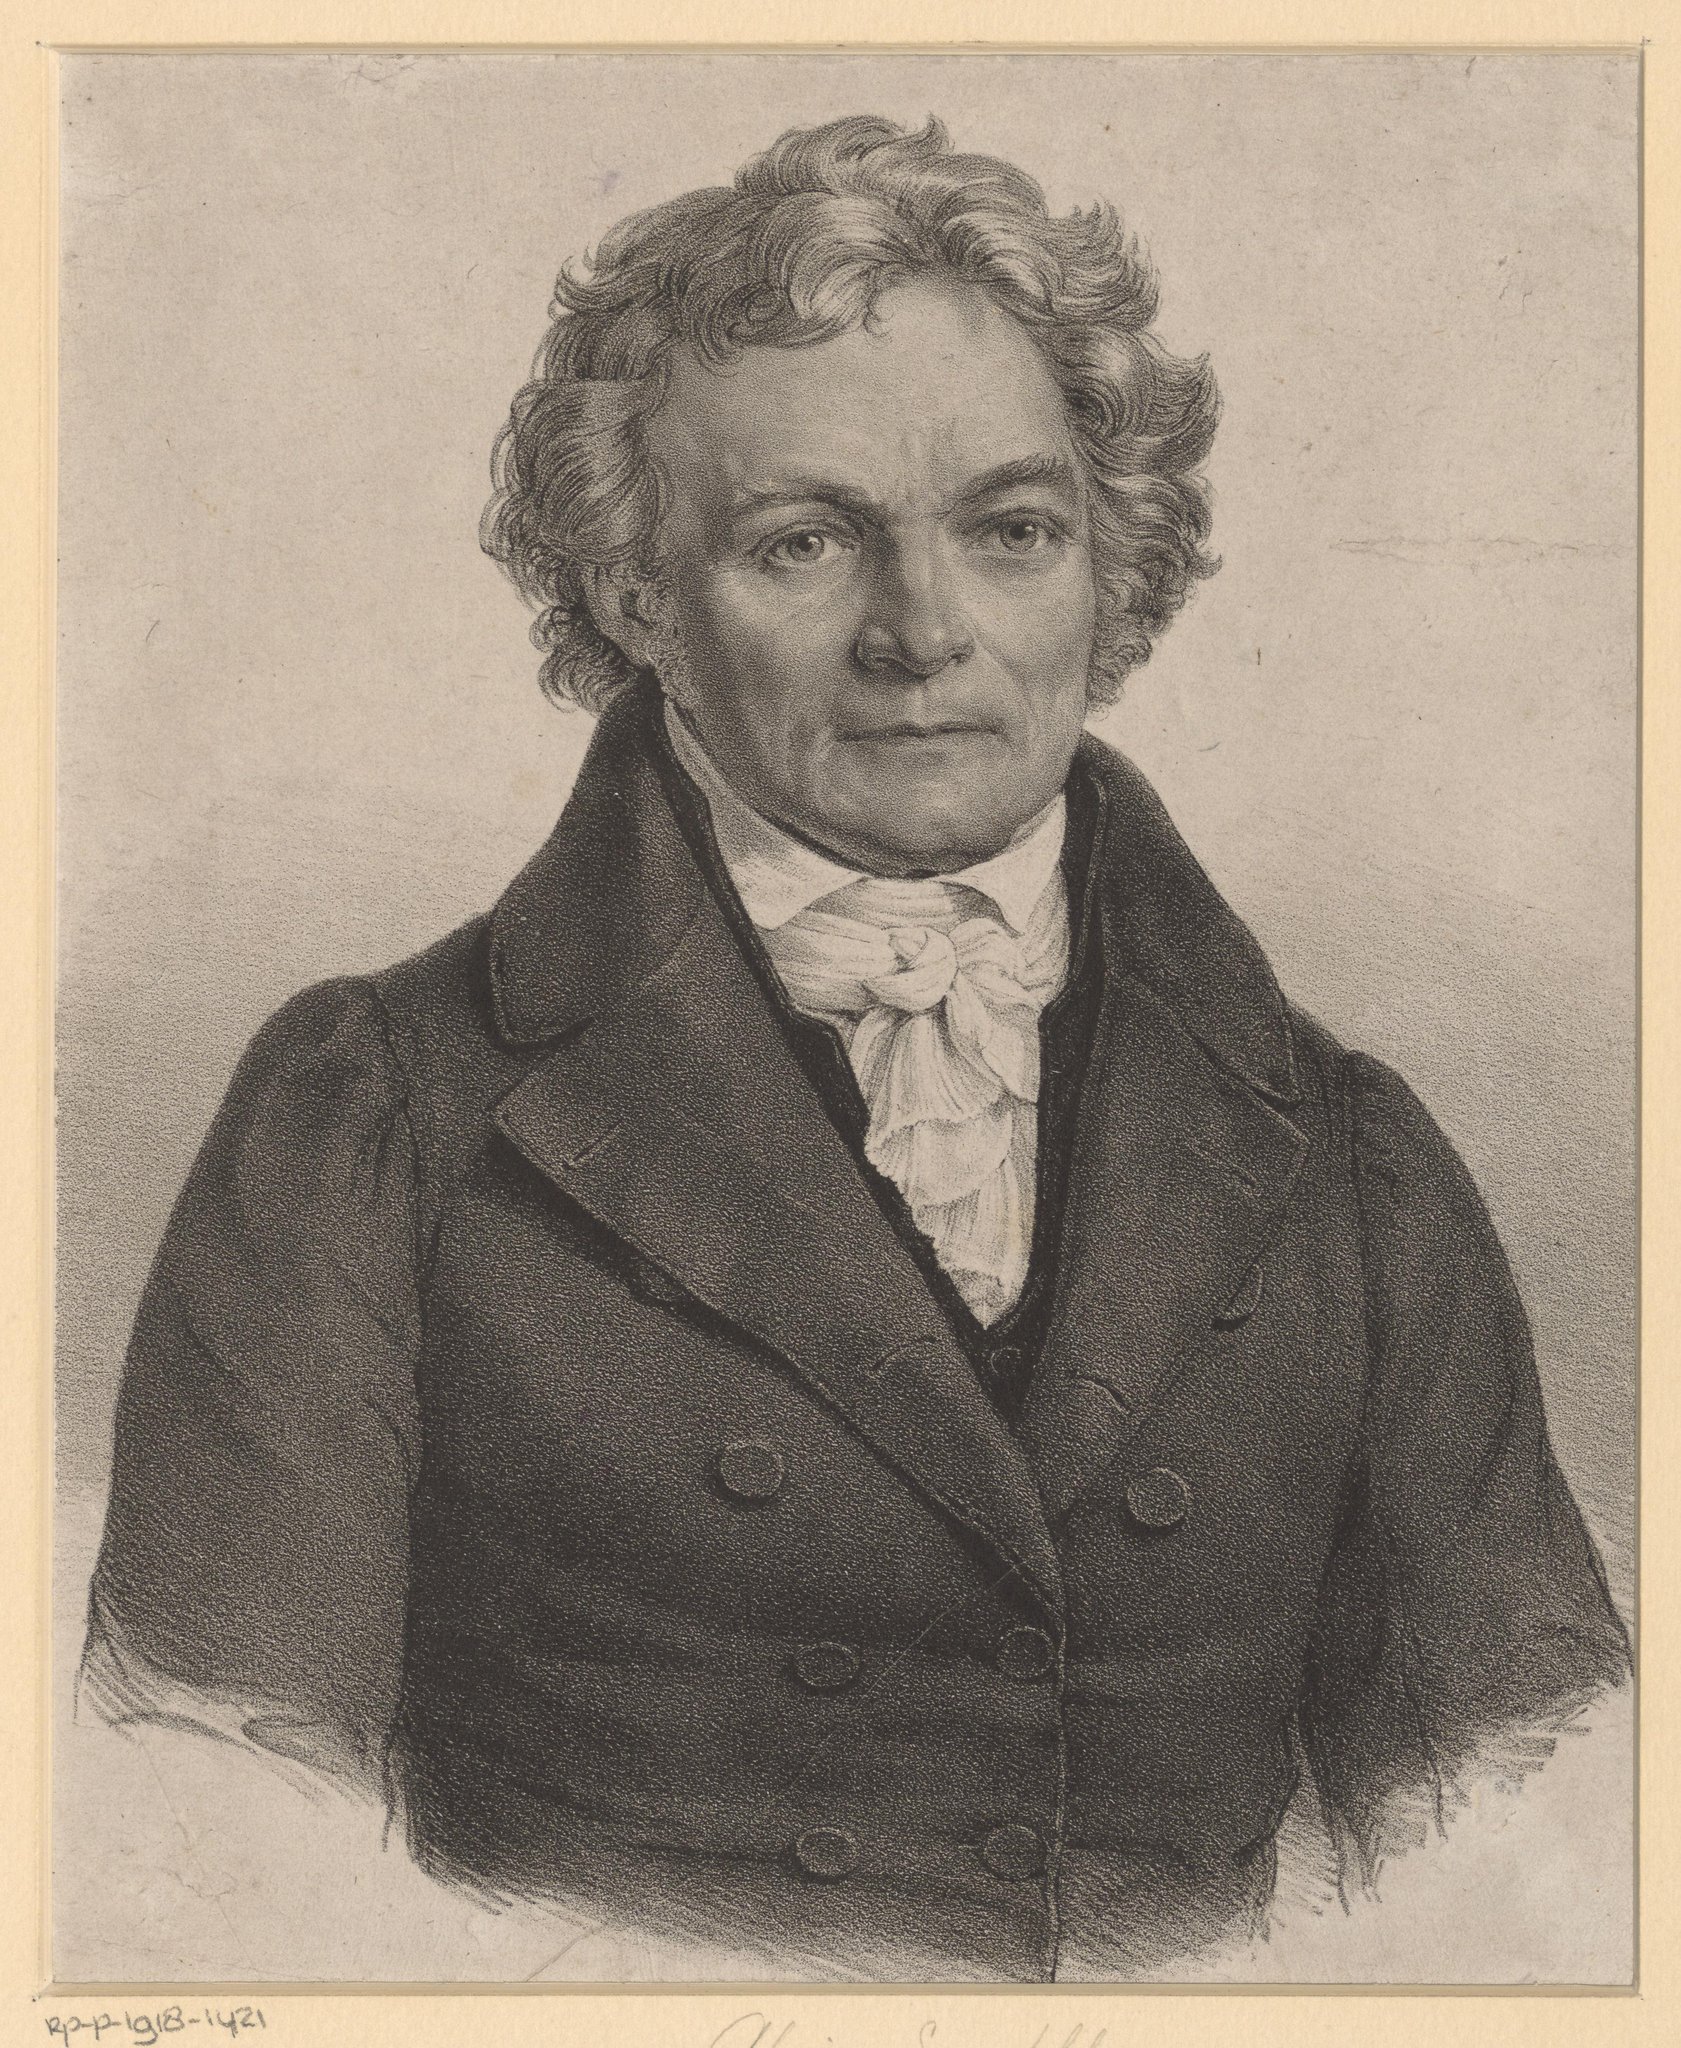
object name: print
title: Portret van Alois Senefelder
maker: Anonymous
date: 1798-1899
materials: paper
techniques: lithograph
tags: prague, print maker, printer, alois senefelder, historical persons, portrait, self-portrait of graphic artist, invention, discovery ~ science and technology